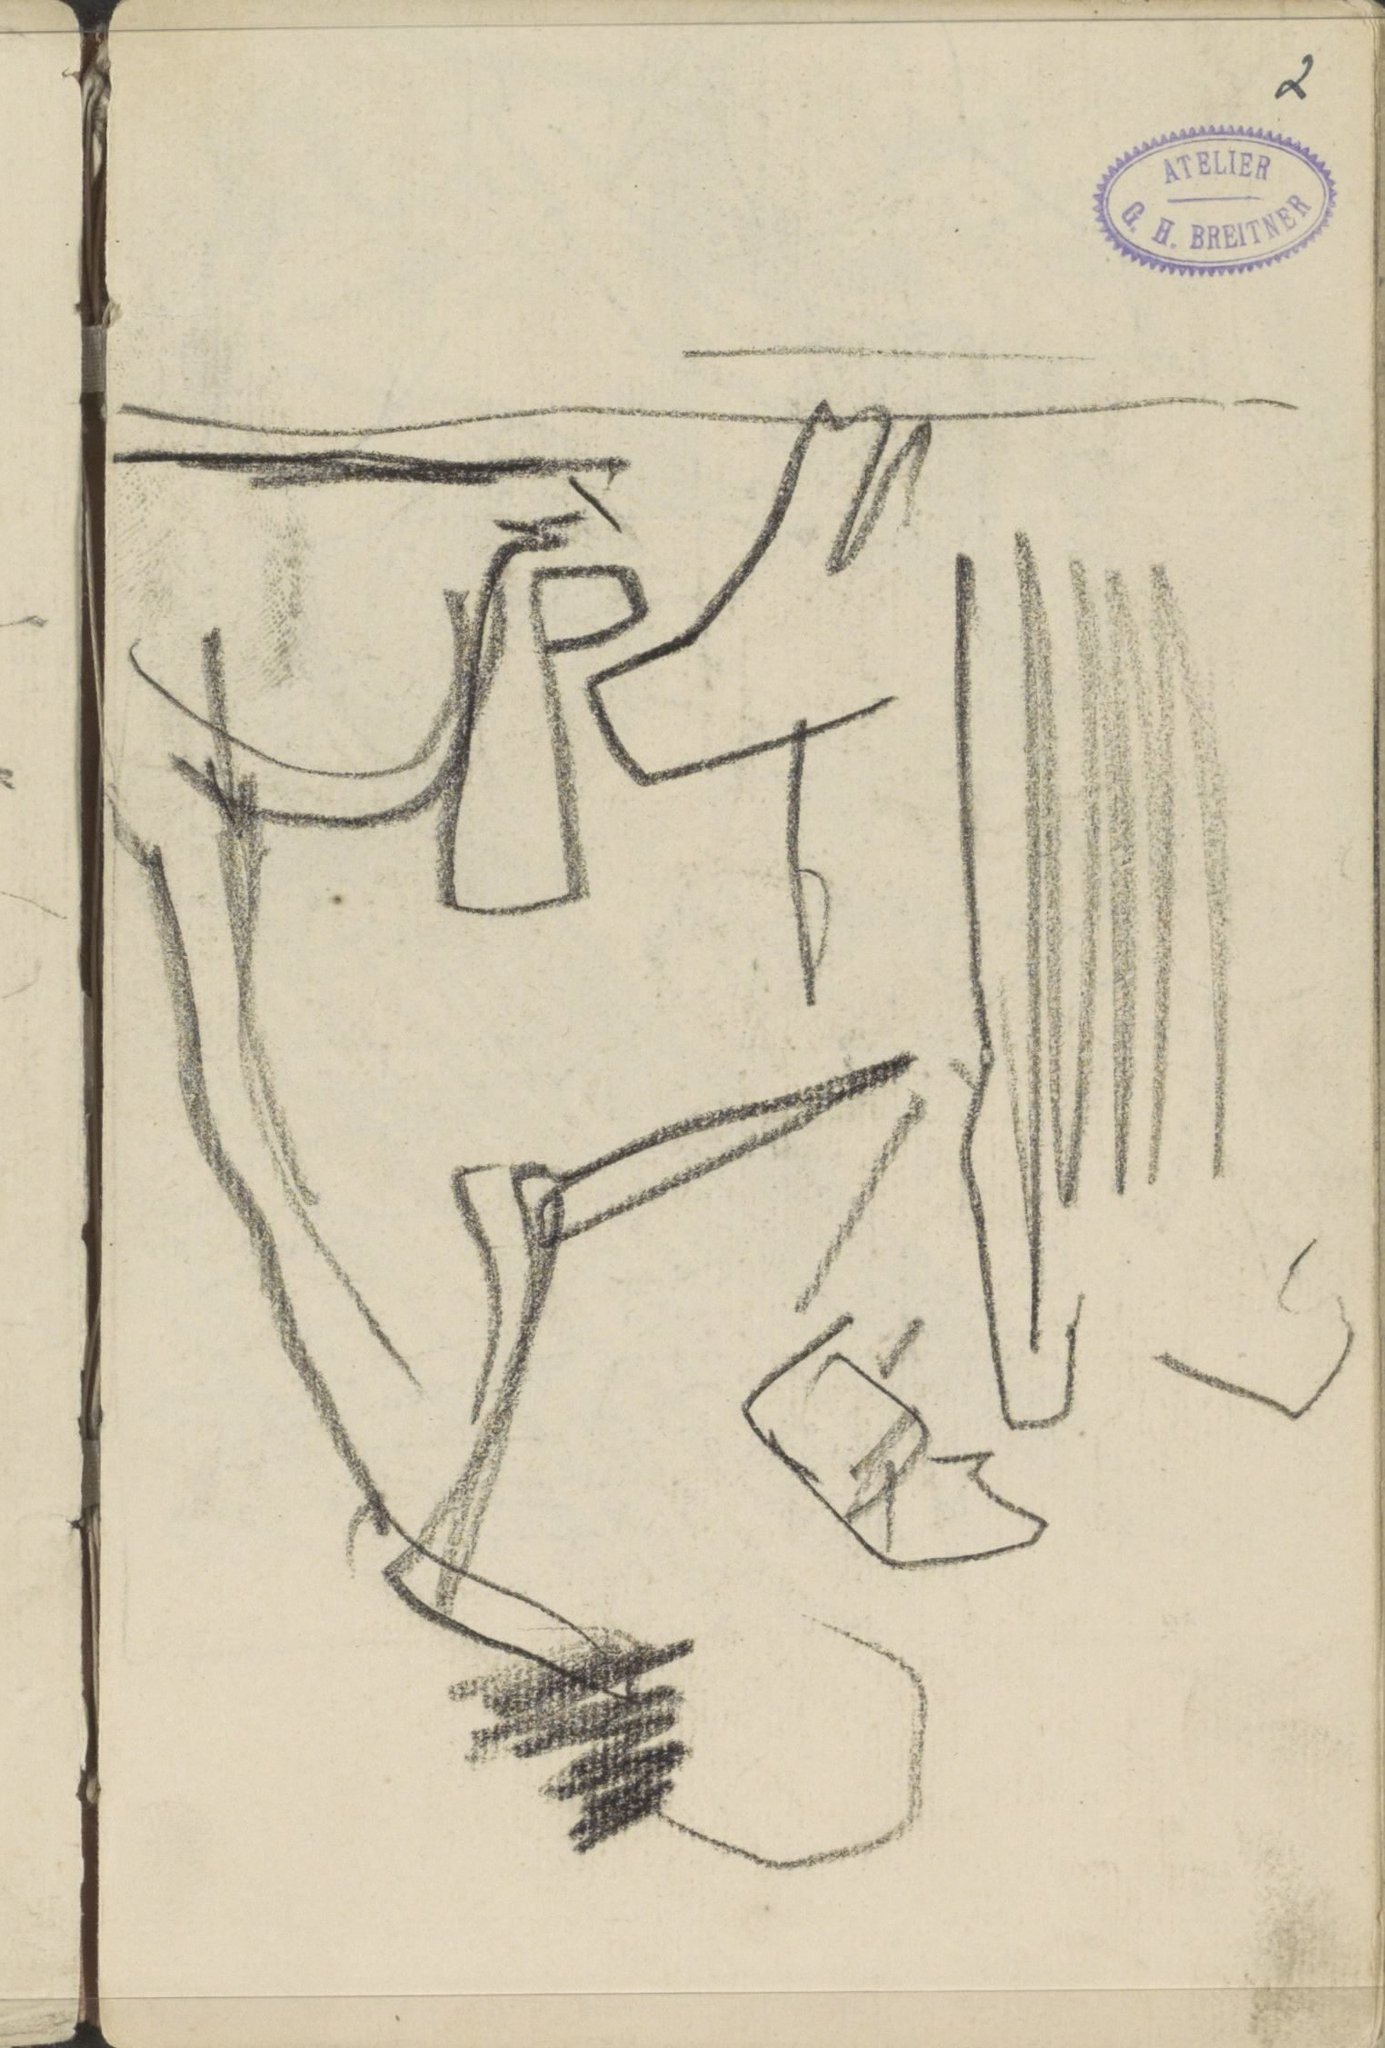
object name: sketchbook leaf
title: Studie, mogelijk een figuurstudie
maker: george hendrik breitner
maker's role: draughtsman, painter, print maker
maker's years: 1857-1923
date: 1881-1883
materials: chalk, paper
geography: the hague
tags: sitting figure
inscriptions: workshop stamp: Lugt 291d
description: Blad 2 recto uit een schetsboek met 9 bladen.